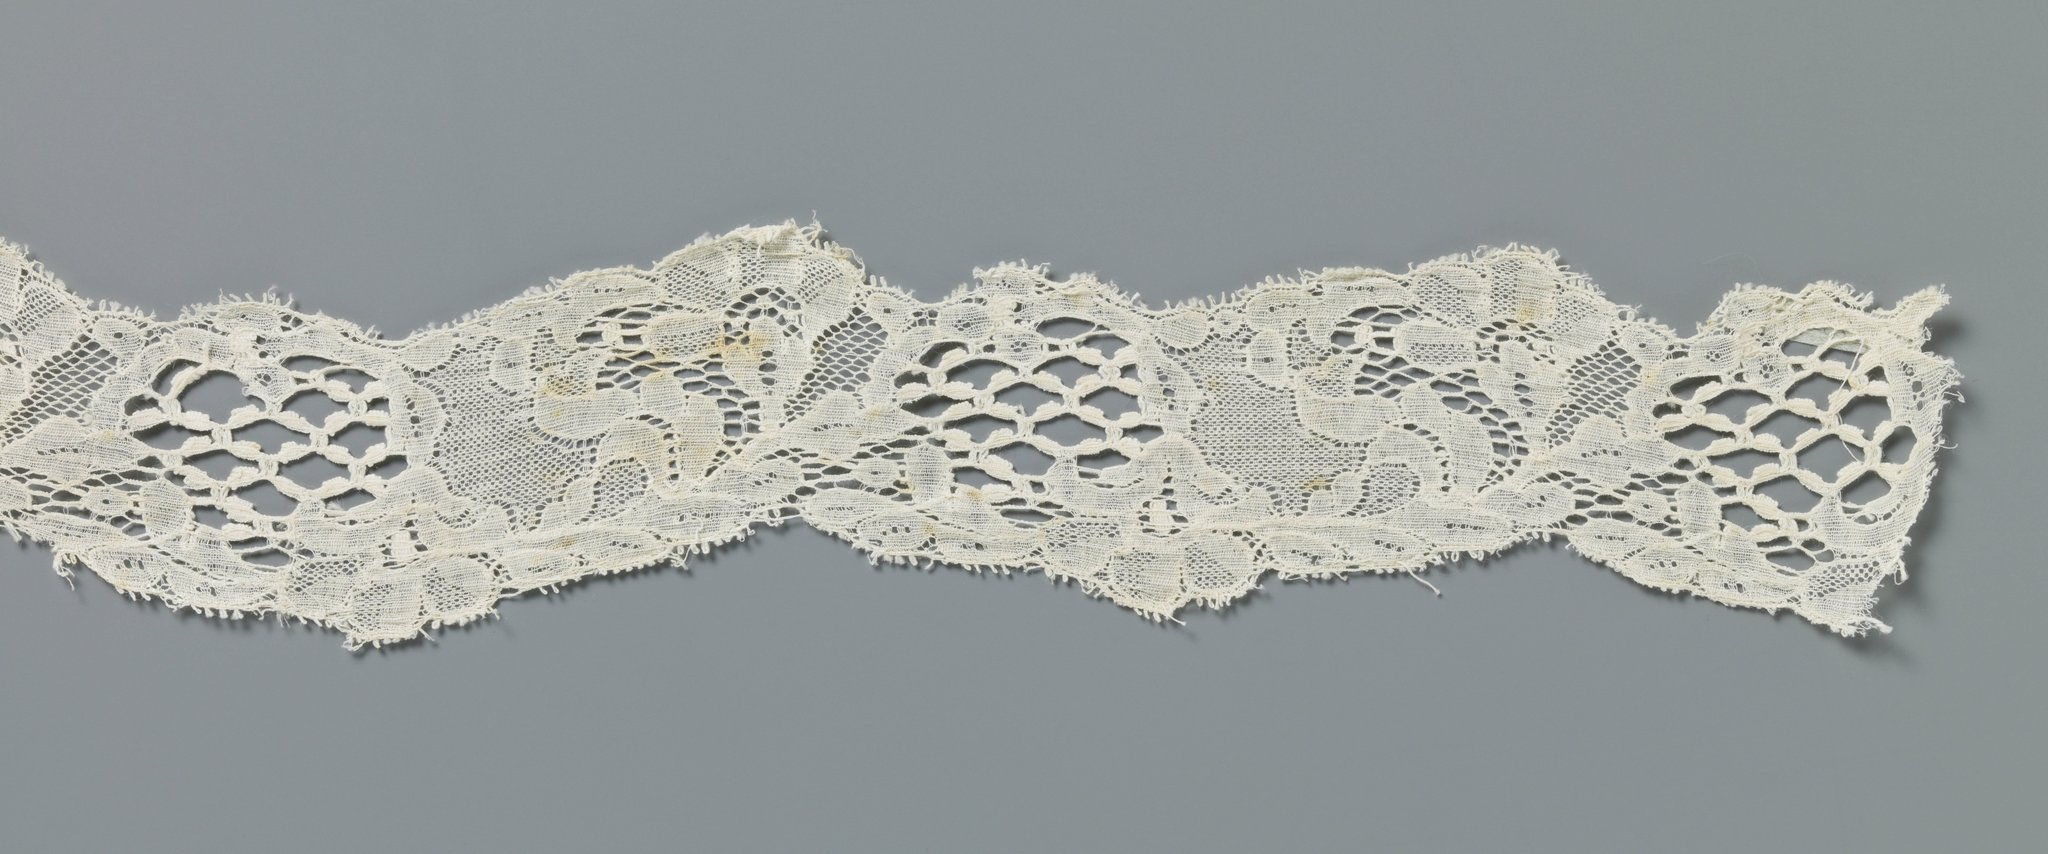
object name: strip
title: Tussenzetsel van machinale kant met zigzaggend model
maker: Anonymous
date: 1890-1914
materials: cotton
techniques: lace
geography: nottingham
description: Tussenzetsel van naturelkleurige machinale kant: machinale Mechelse kant. De strook heeft een flauw zigzaggend model. Het zich herhalende patroon bestaat uit een bloem langs de ene lange zijde en een bloem langs de andere lange zijde die met bladeren aan elkaar verbonden zijn. Eén bladstengel vormt een min of meer ronde lijst, gevuld met een rasterwerk van kruisjes, gemaakt met machinale vormslagen. De motieven zijn dichtgewerkt met enkele uitsparingen en voorzien van contourdraden. Ze zijn met elkaar verbonden door verschillende machinale traliegronden, onder andere met een machinale Mechelse grond. De lange zijden zijn afgewerkt met picots.